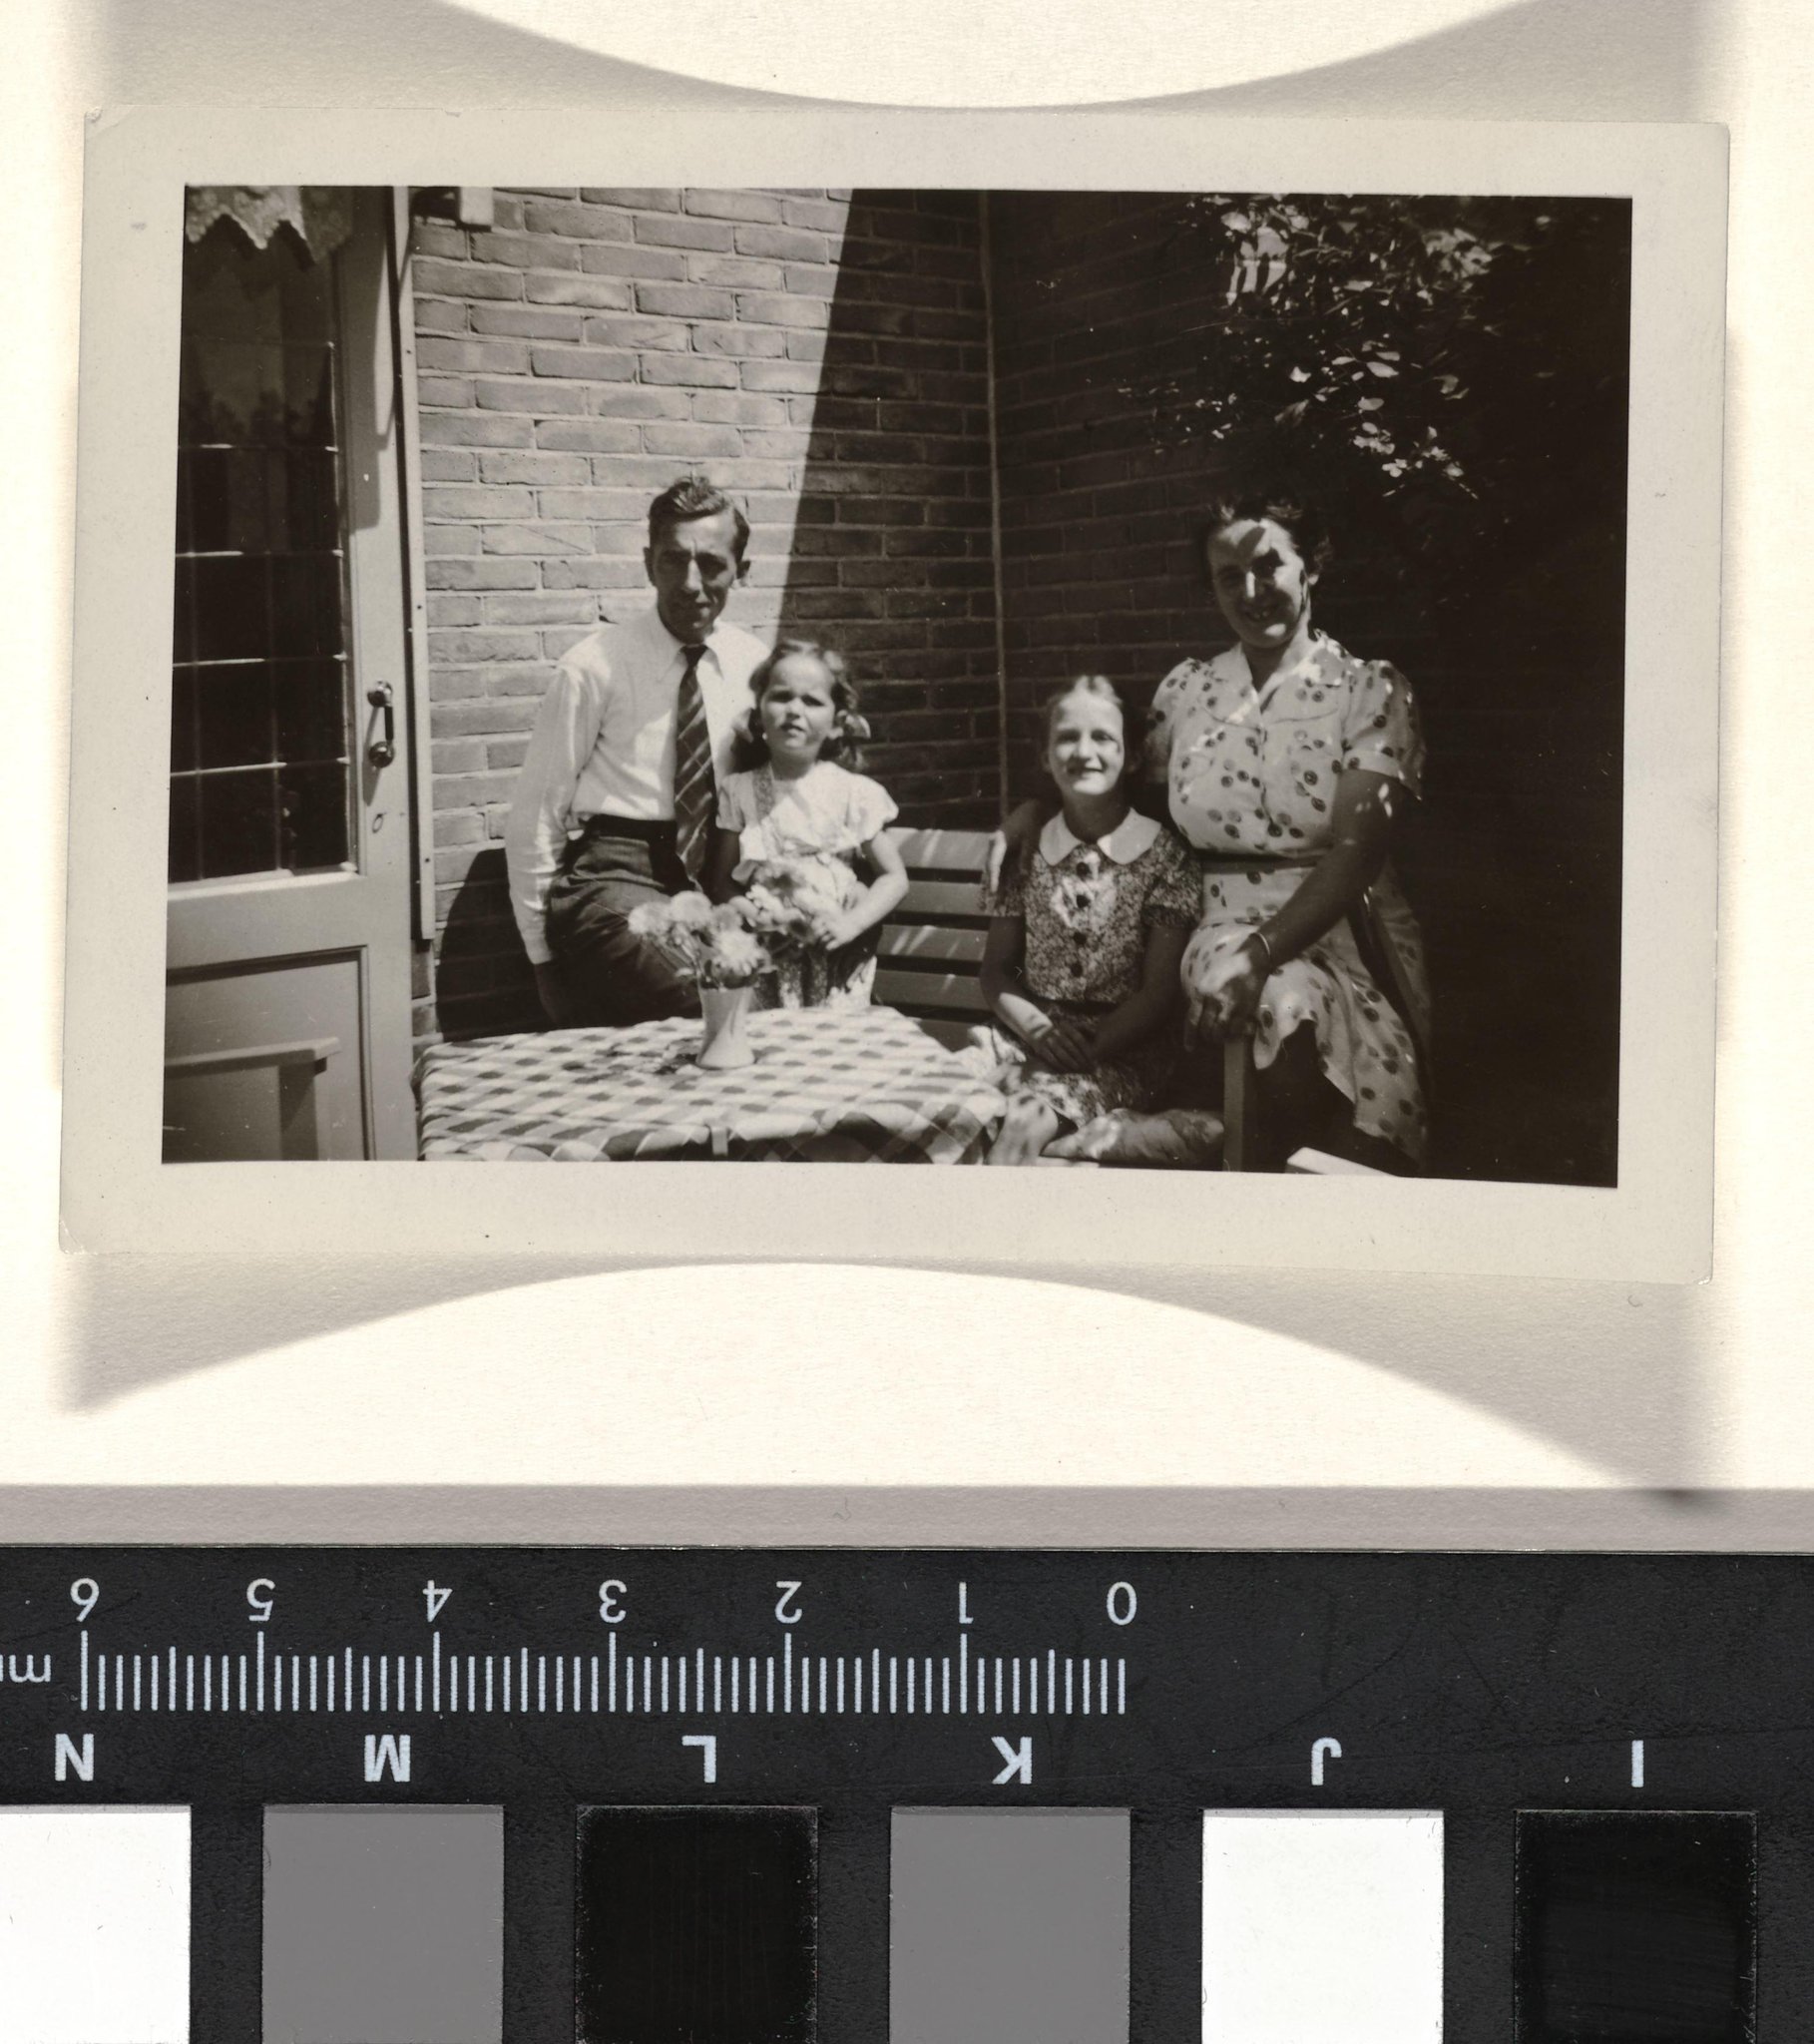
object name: photograph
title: Vier onbekende personen, gezeten buiten met een stenen muur op de achtergrond en een geblokt tafelkleed op de voorgrond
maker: Anonymous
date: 1907-1947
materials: photographic support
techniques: gelatin silver print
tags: doorn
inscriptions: date: ‘Doorn. Juli 47’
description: Vier onbekende personen, gezeten buiten met een stenen muur op de achtergrond en een geblokt tafelkleed op de voorgrond.